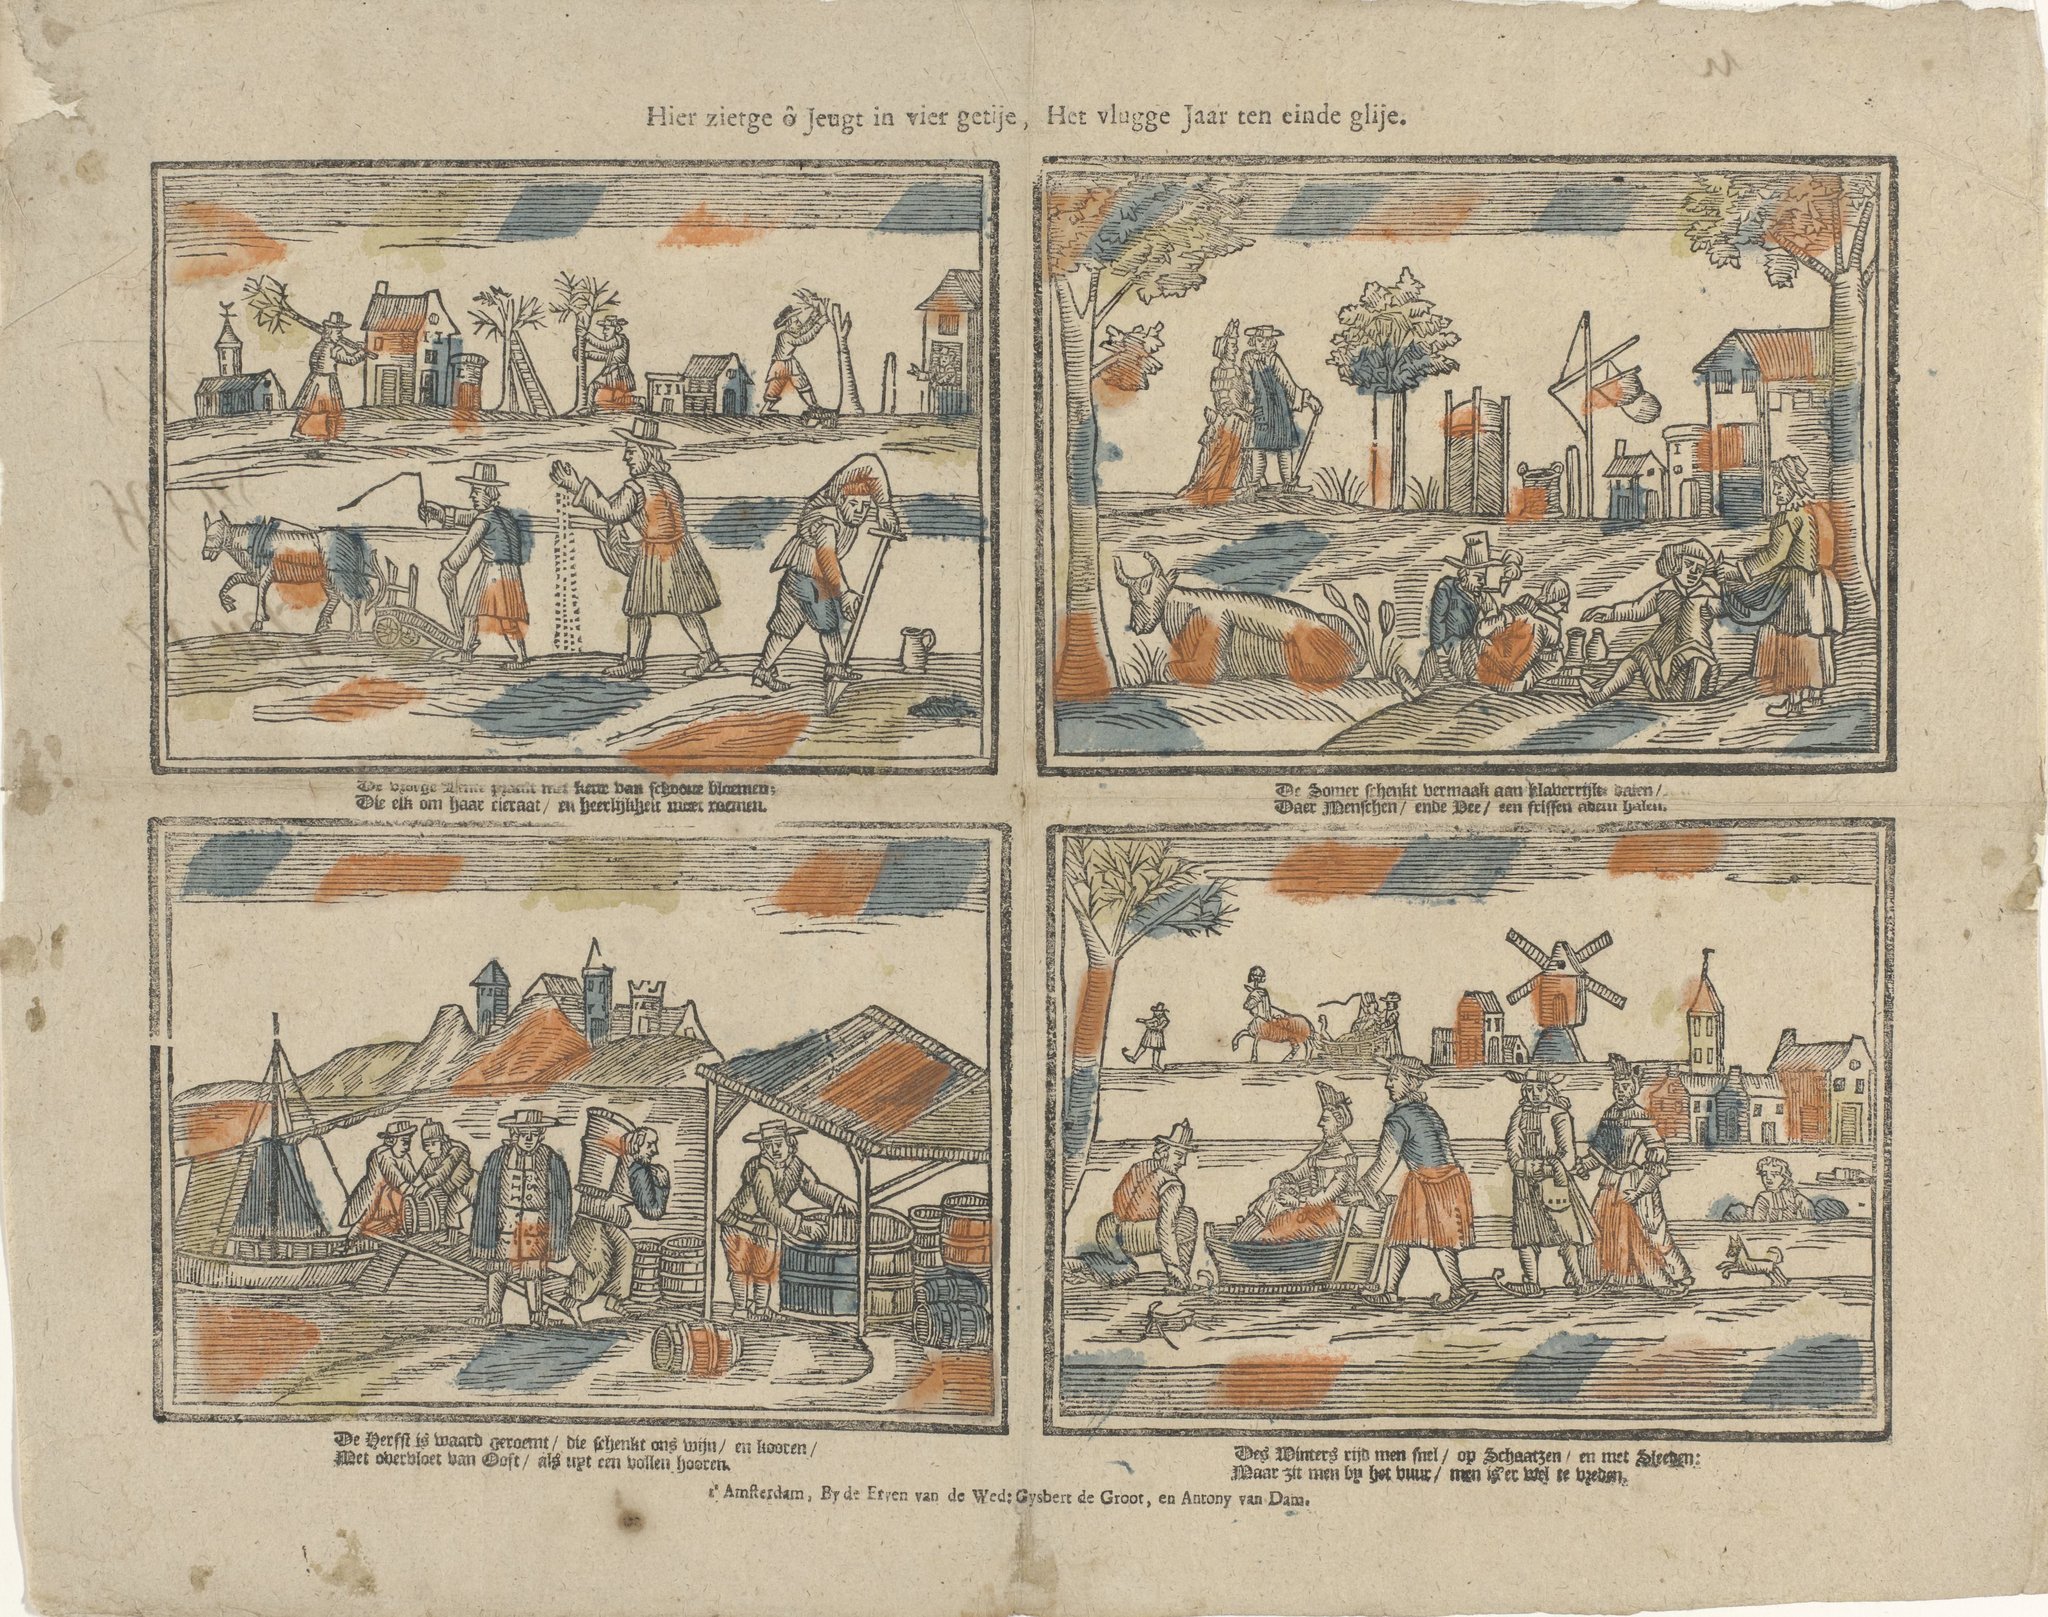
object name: popular print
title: Hier zietge ô jeugt in vier getije, Het vlugge jaar ten einde glije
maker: Anonymous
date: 1725-1738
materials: paper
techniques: colour, letterpress printing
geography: amsterdam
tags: the four seasons of the year ~ human activities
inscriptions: collector's mark: Lugt 2760, collector's mark: Lugt 2228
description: Blad met 4 voorstellingen van de vier jaargetijden en kenmerkende activiteiten voor het seizoen, zoals zaaien in de lente en schaatsen in de winter. Onder elke afbeelding een tweeregelig vers.